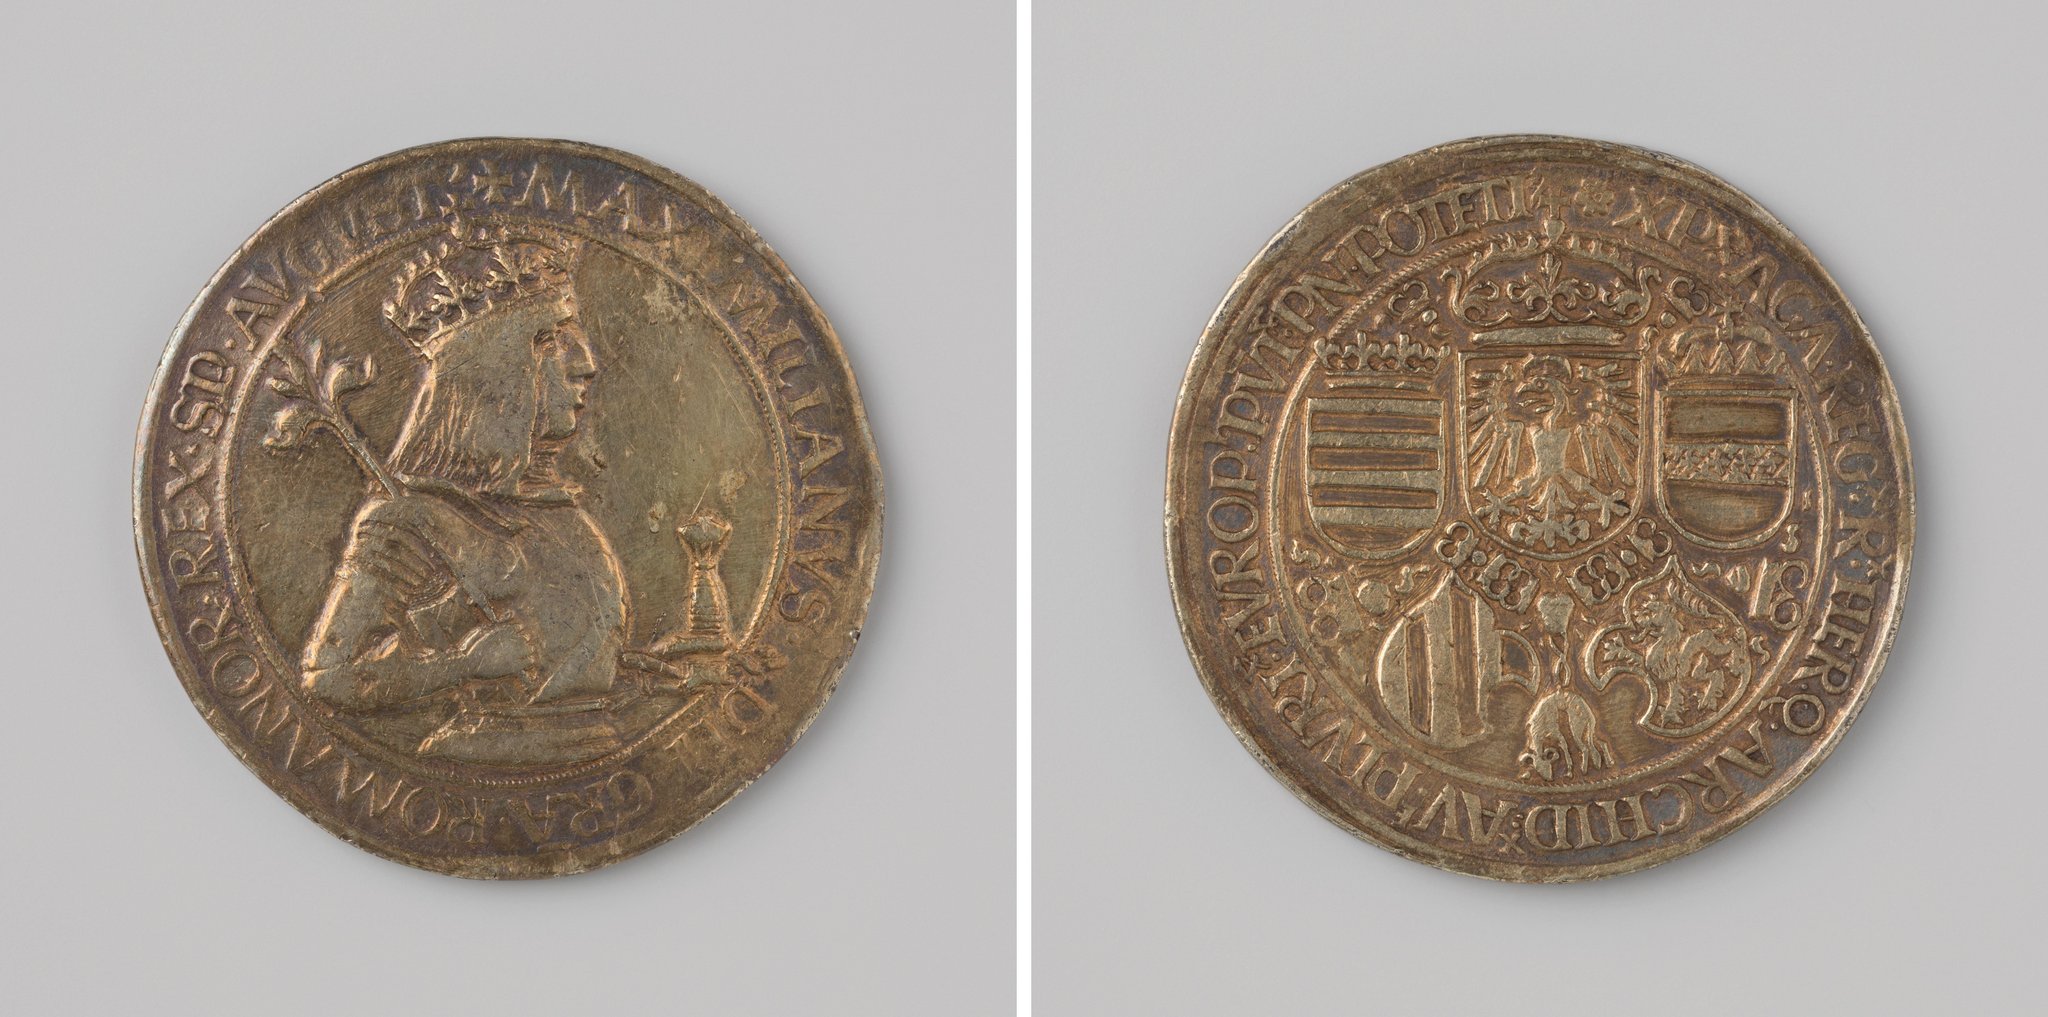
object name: schauguldiner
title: Schauguldiner (taler) van Maximiliaan I, Duits keizer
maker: benedict burgkart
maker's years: 1496-1508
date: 1490-1519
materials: silver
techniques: gilding, striking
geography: hall am inn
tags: maximilian i (holy roman emperor)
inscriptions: circumscription: ‘* XPs . AC . A . REGx . Rx . HER . Q . ARCHIDx . AVe . PLVRIx . EVROPi . PVIx . PN . POTETIx’, circumscription: ‘+ MAXIMILIANVS . - . DEI . GRA . ROMANOR . REX . SP . AVGVST'’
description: Zilveren munt. Voorzijde: borststuk man (Maximiliaan I) met kroon, zwaard en scepter binnen omschrift. Keerzijde: gekroond wapenschild met daaraan orde van Gulden Vlies tussen twee gekroonde wapenschilden, boven twee wapenschilden binnen omschrift